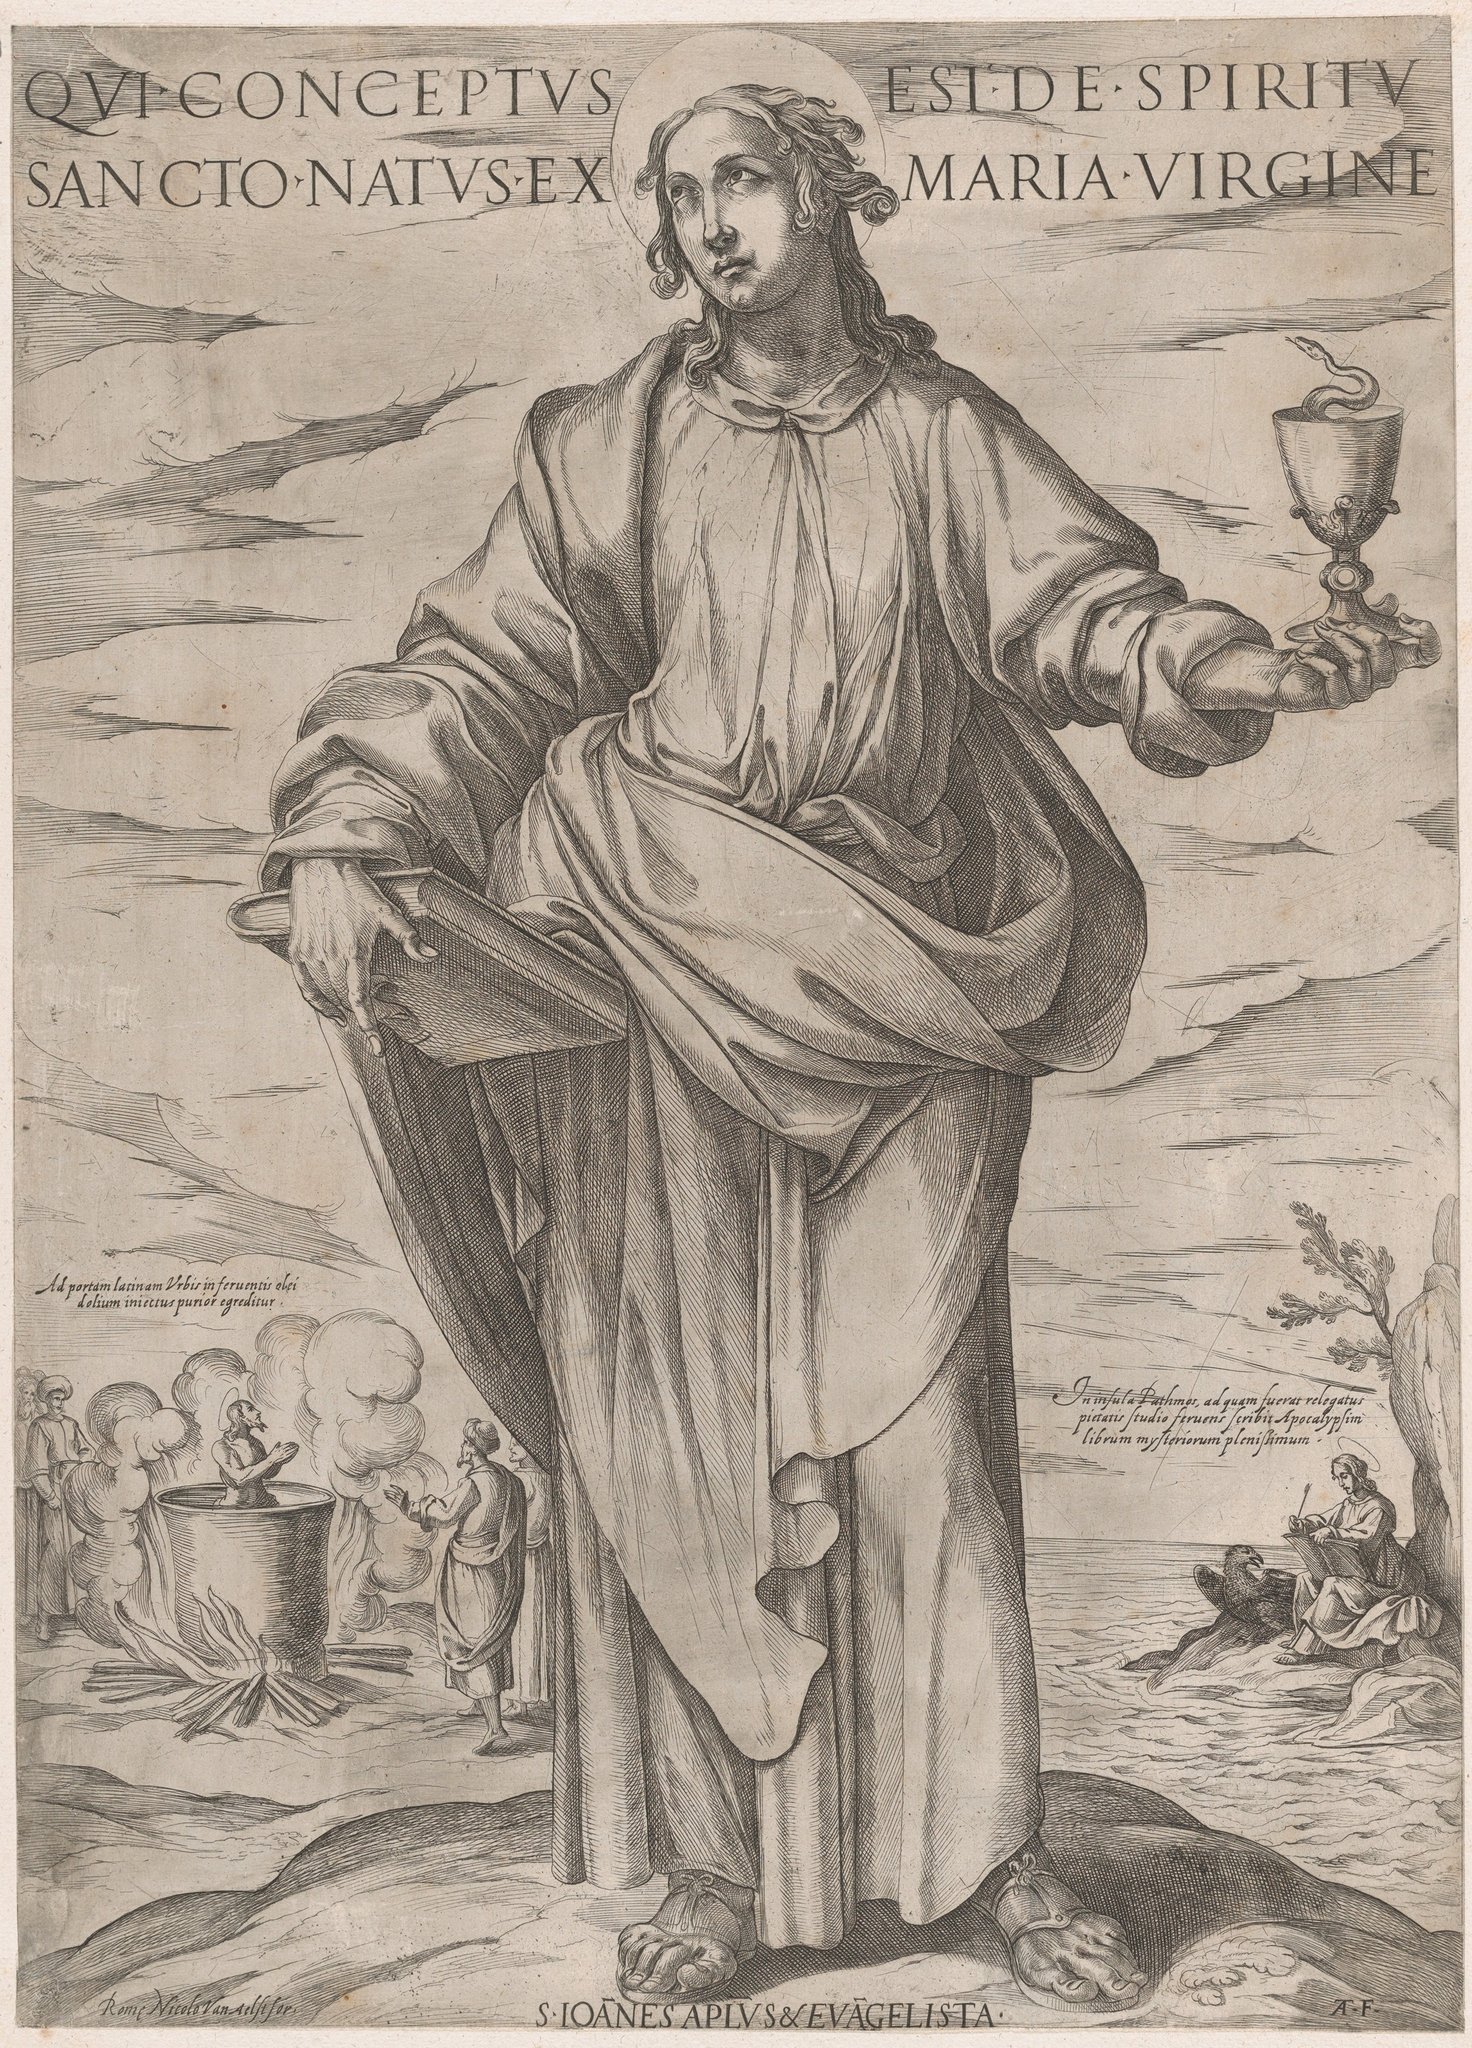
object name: print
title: St. John the Evangelist, from "Christ, Mary and the Apostles"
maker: antonio tempesta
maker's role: artist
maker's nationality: italian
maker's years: 1555-1630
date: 1590-1610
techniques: etching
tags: men,saint john the evangelist,punishment